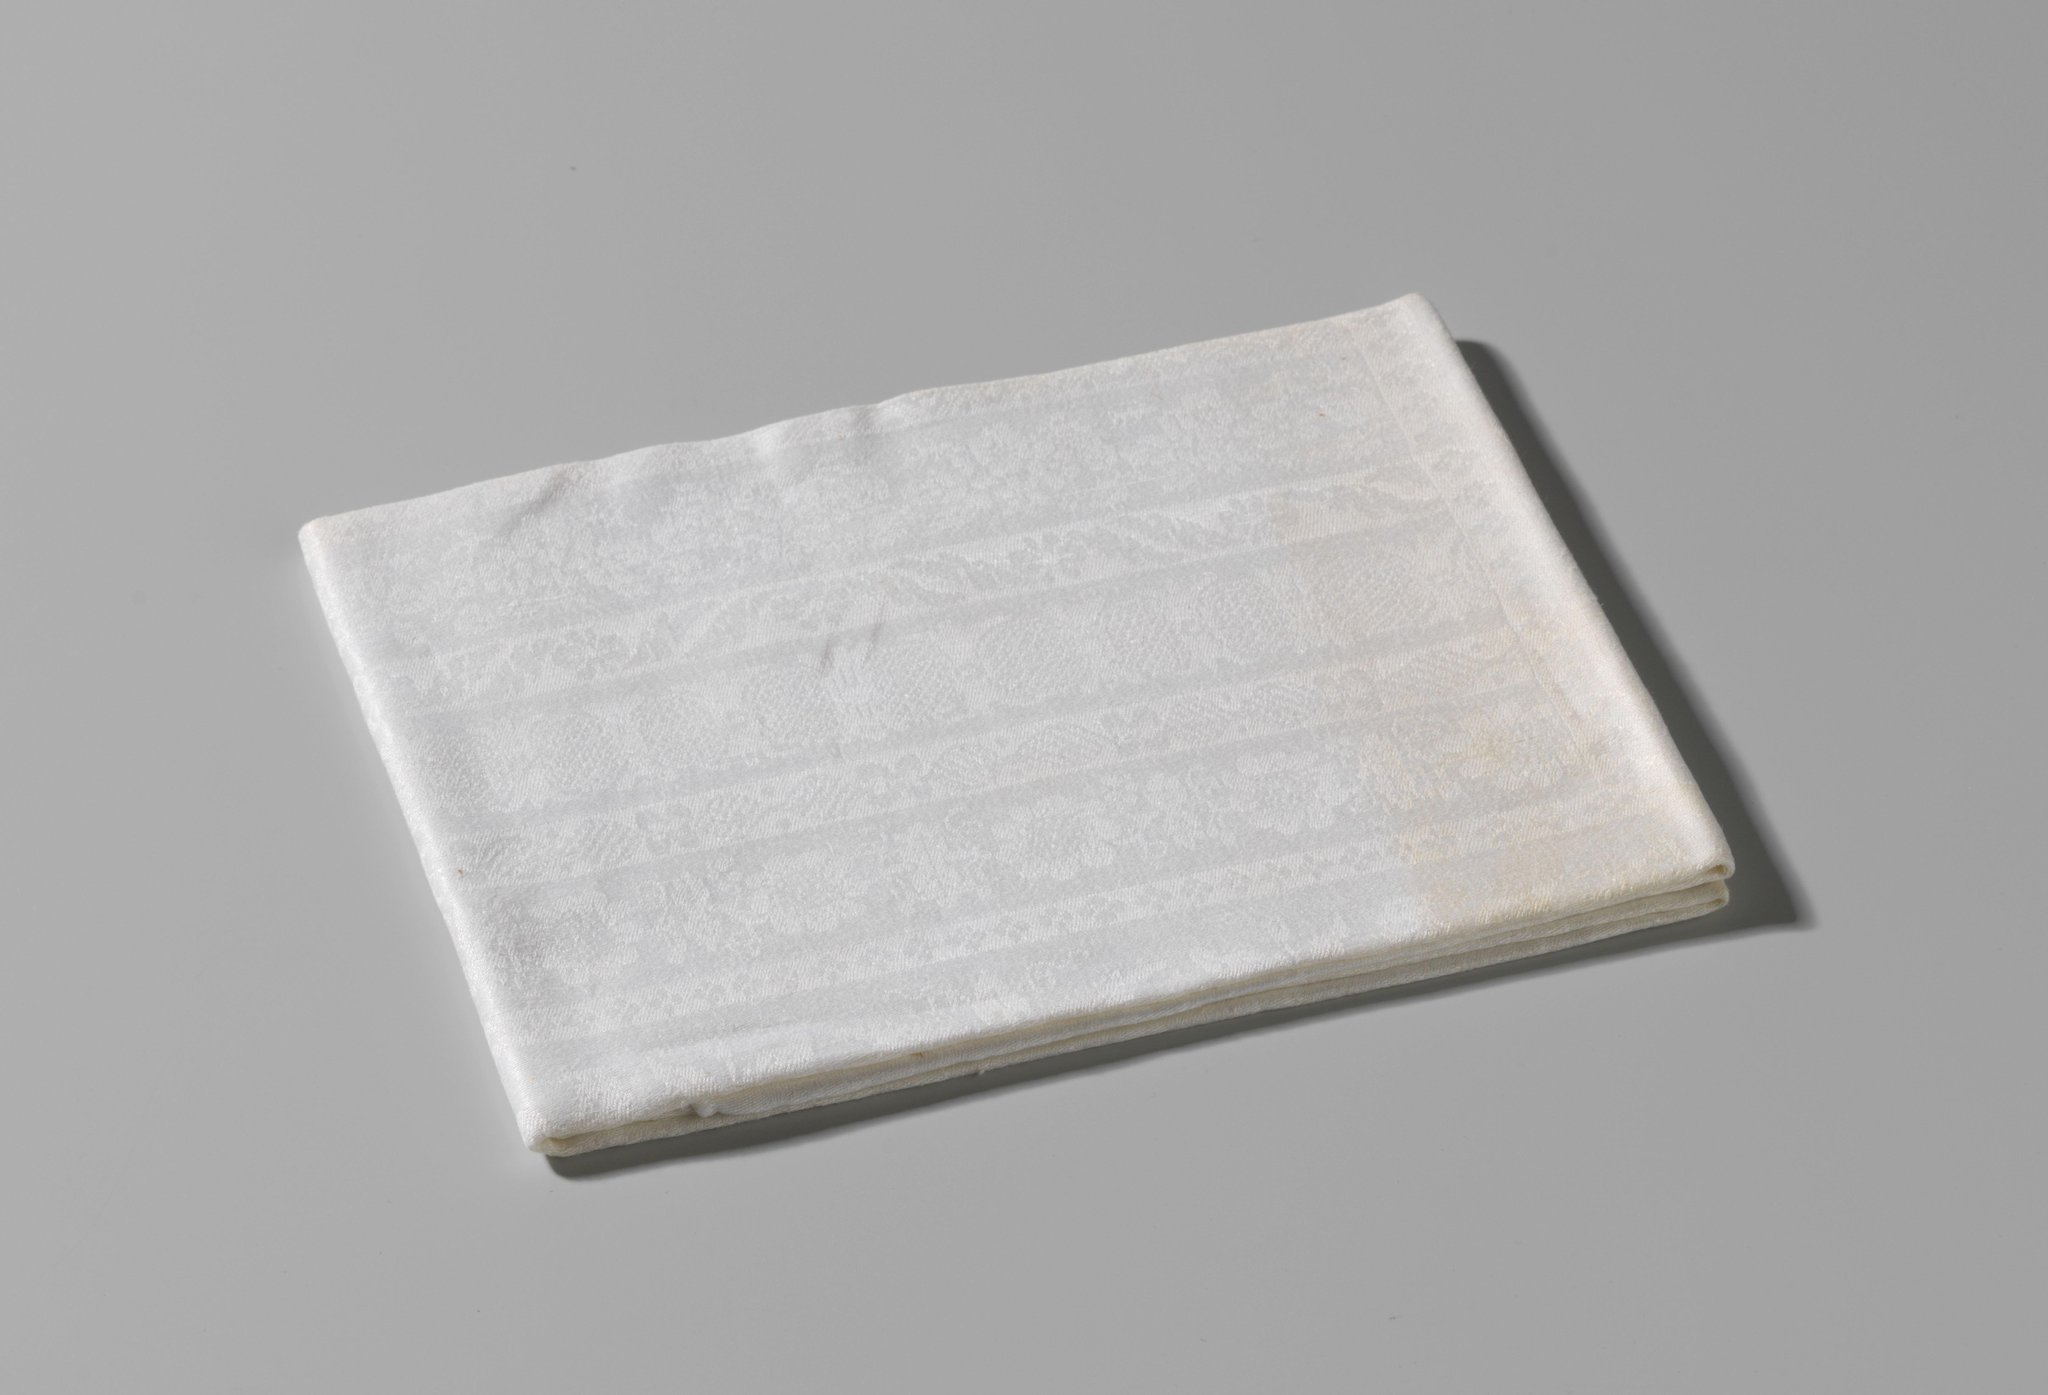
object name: napkin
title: Servet van damast met geornamenteerde lengtestrepen binnen een rand met voluten, bloemen en een bloemenmand.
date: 1840-1860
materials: linen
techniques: damask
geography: netherlands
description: Wit linnen damasten servet met geornamenteerde lengtestrepen binnen een rand met voluten, bloemen en een bloemenmand. Gemerkt: WdW en 24.